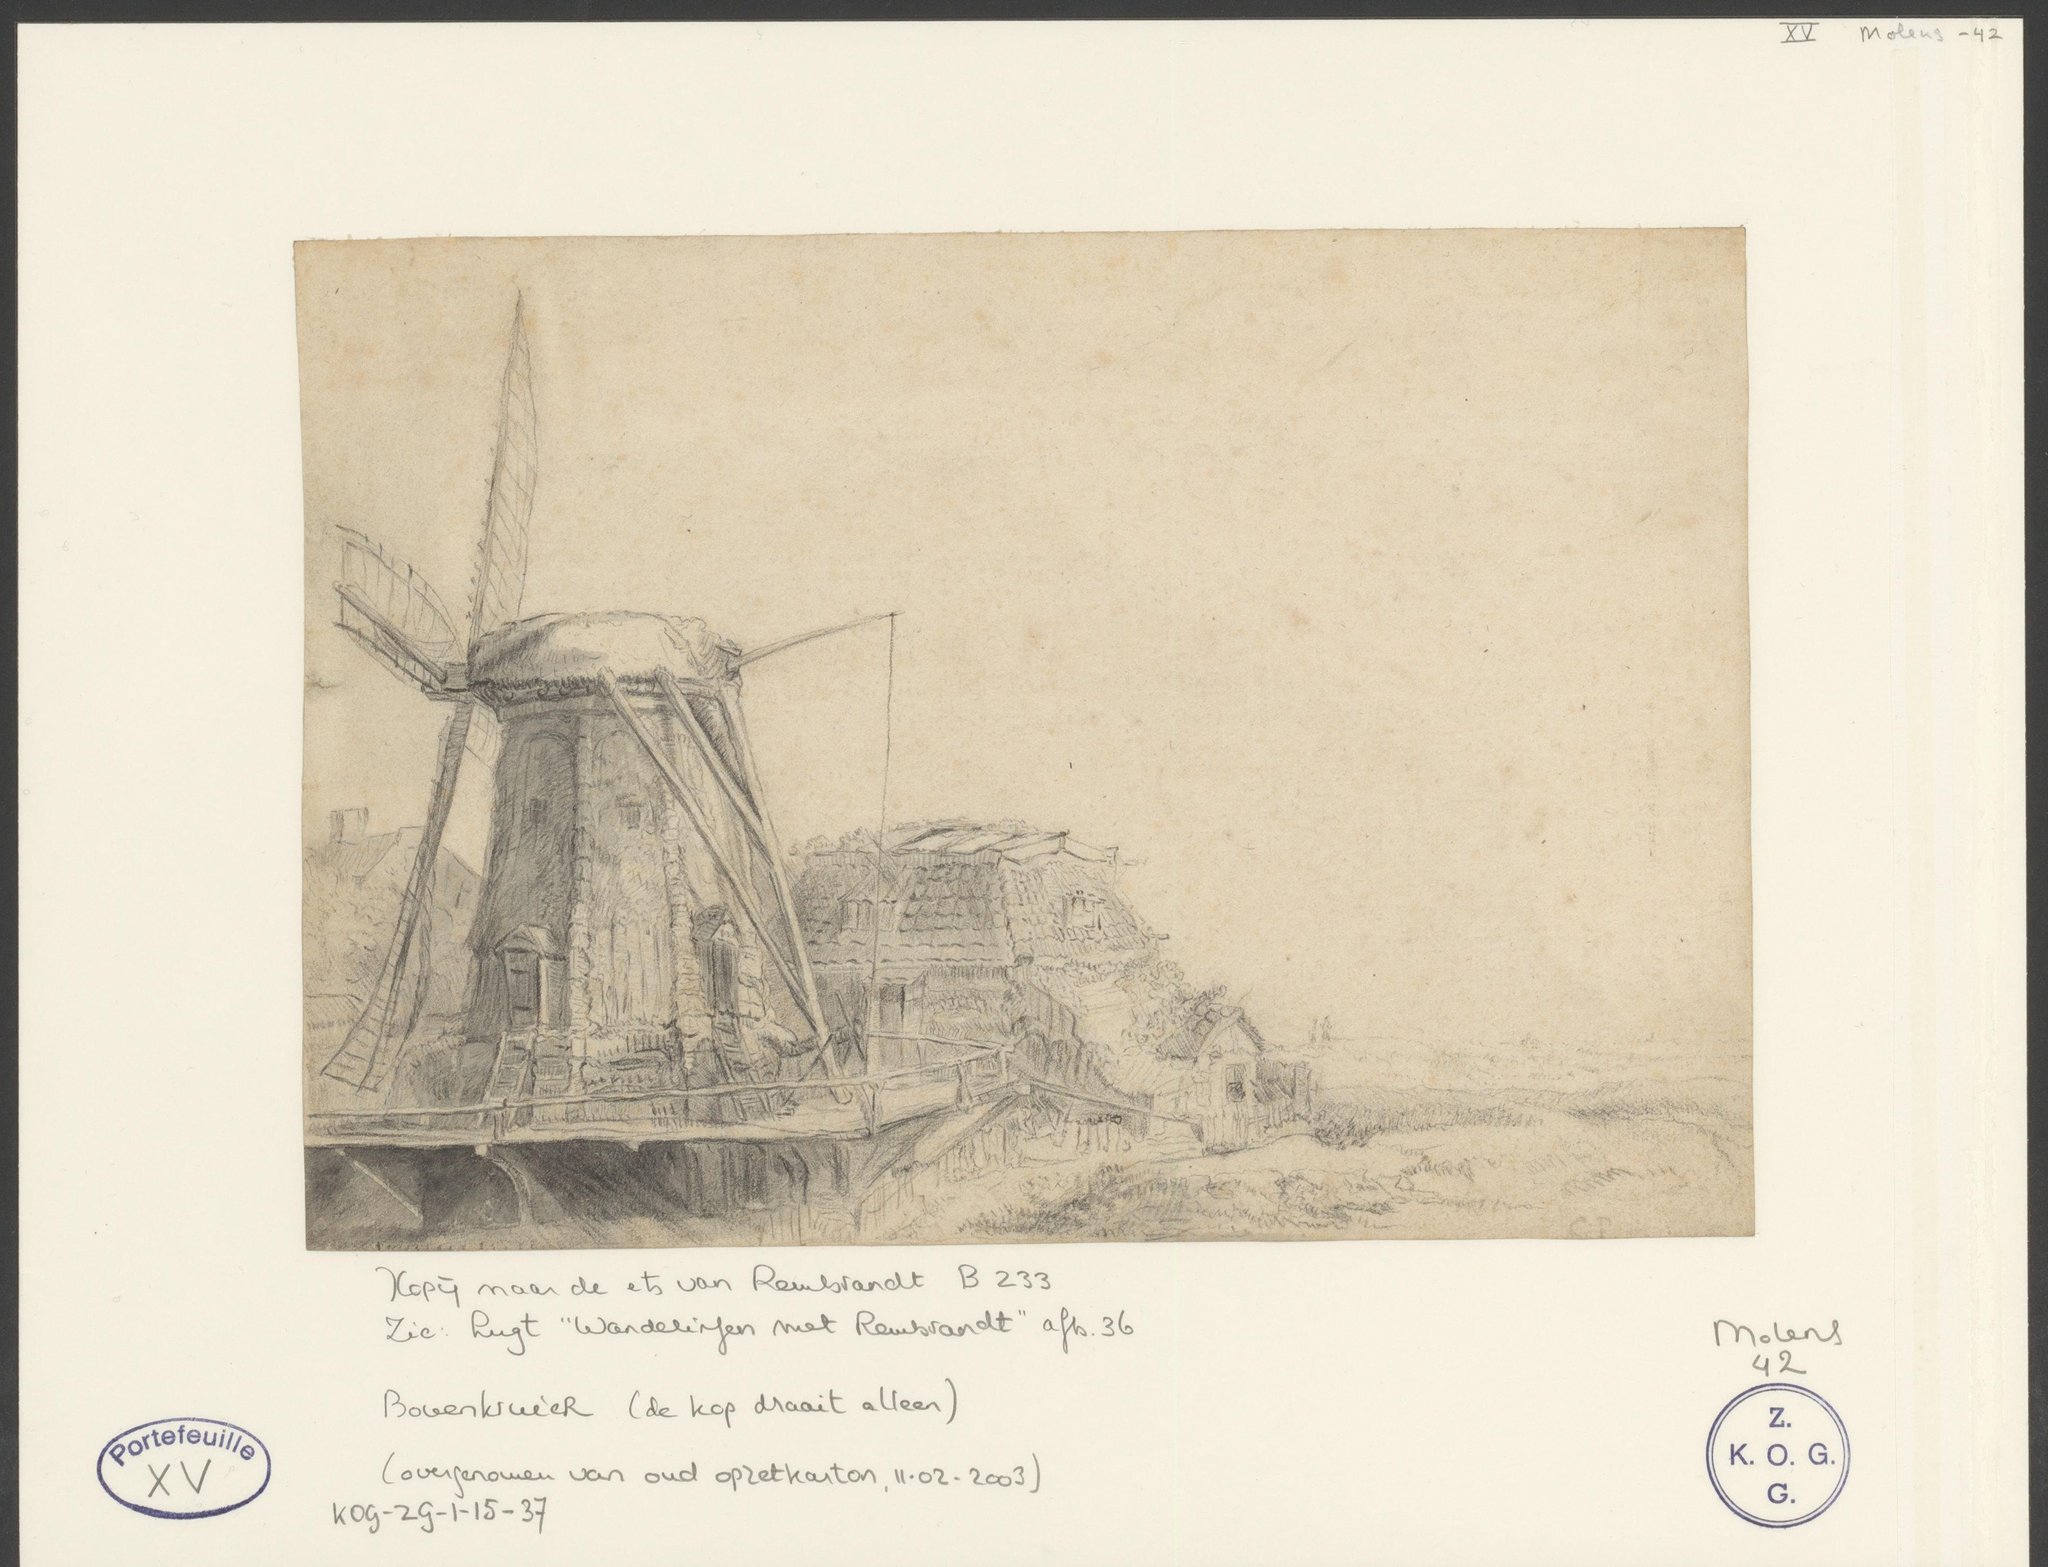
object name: drawing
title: Molen in een landschap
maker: Anonymous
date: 1800-1899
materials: chalk, paper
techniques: brush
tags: windmill in landscape, windmill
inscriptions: collector's mark: Lugt 1641, stamp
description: Bovenkruier in een landschap. Onderwerpsrubrieken binnen de Atlas Zeden en Gewoonten: Handel, nijverheid en verkeer, Molens.